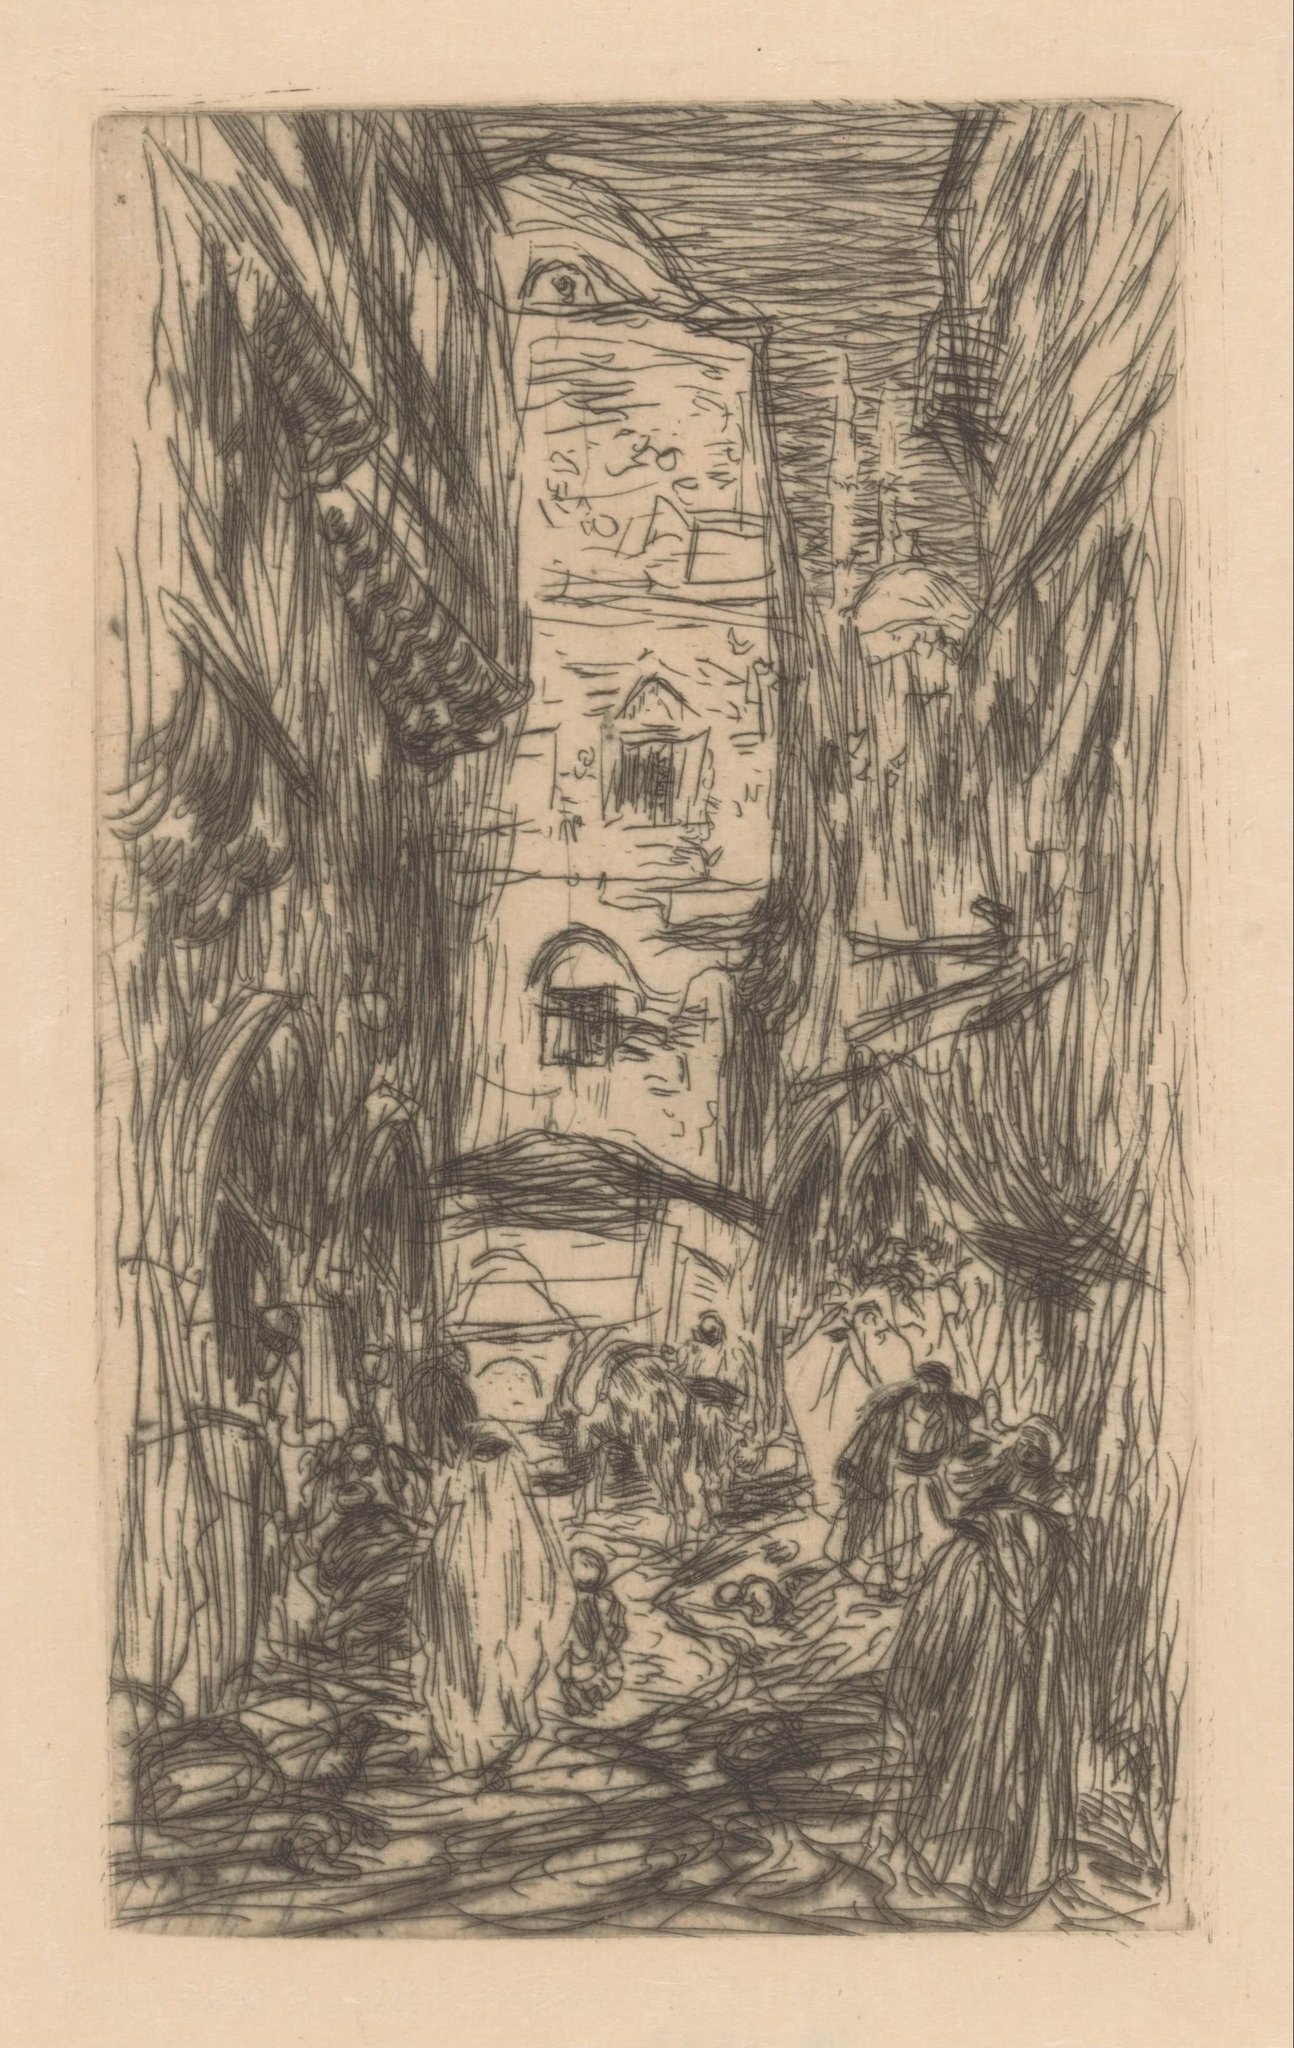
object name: print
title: Straat in Constantinopel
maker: marius bauer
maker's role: draughtsman, print maker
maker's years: 1867-1932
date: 1888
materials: paper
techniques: etching, intaglio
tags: temple, shrine ~ islam, mohammedanism, street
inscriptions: collector's mark: Lugt 2228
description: Een straat met mensen in oosterse kleding. Rechts op de achtergrond twee minaretten van een moskee.